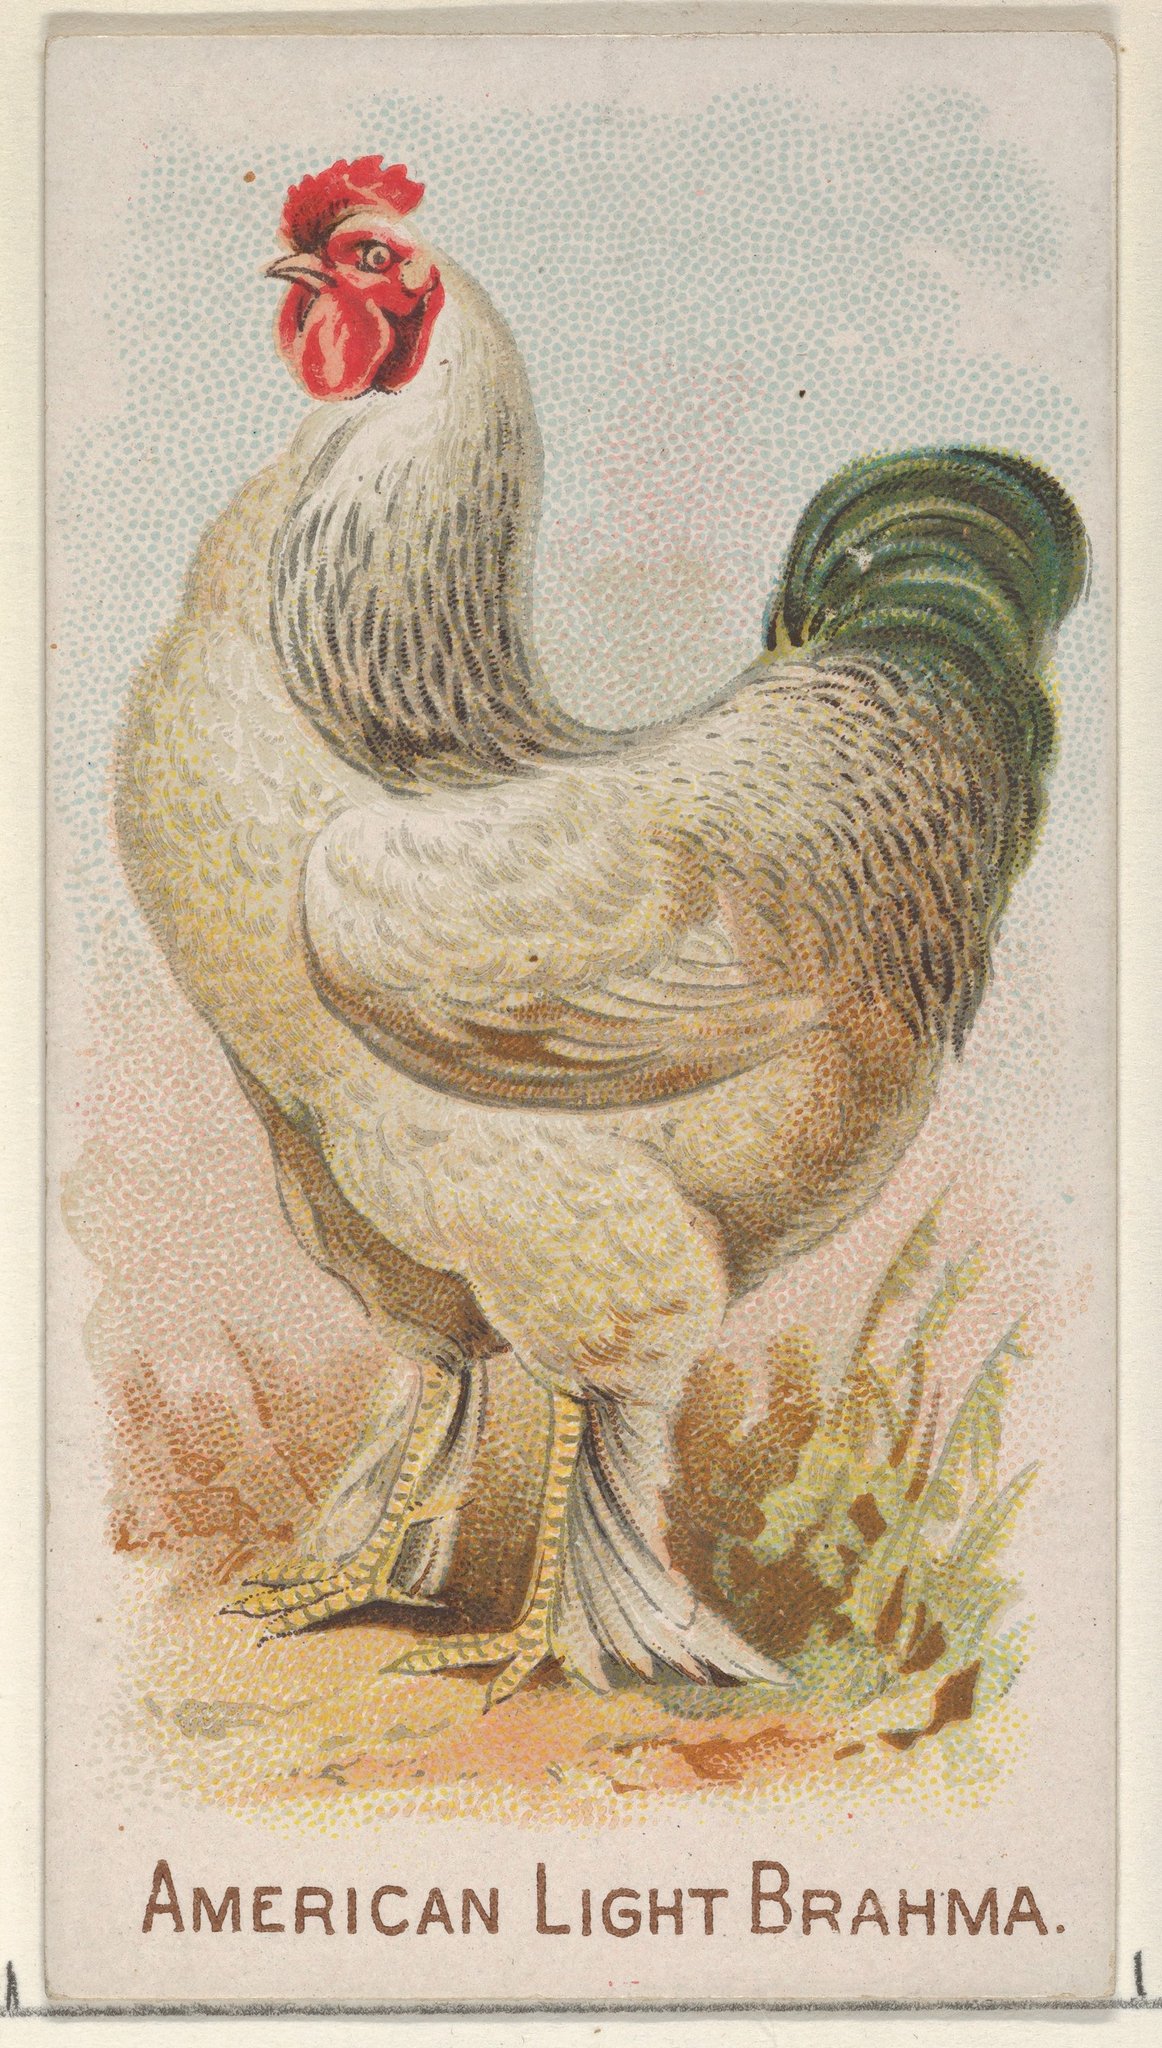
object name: print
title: American Light Brahma, from the Prize and Game Chickens series (N20) for Allen & Ginter Cigarettes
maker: allen & ginter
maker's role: publisher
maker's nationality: american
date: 1891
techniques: color lithograph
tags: chickens